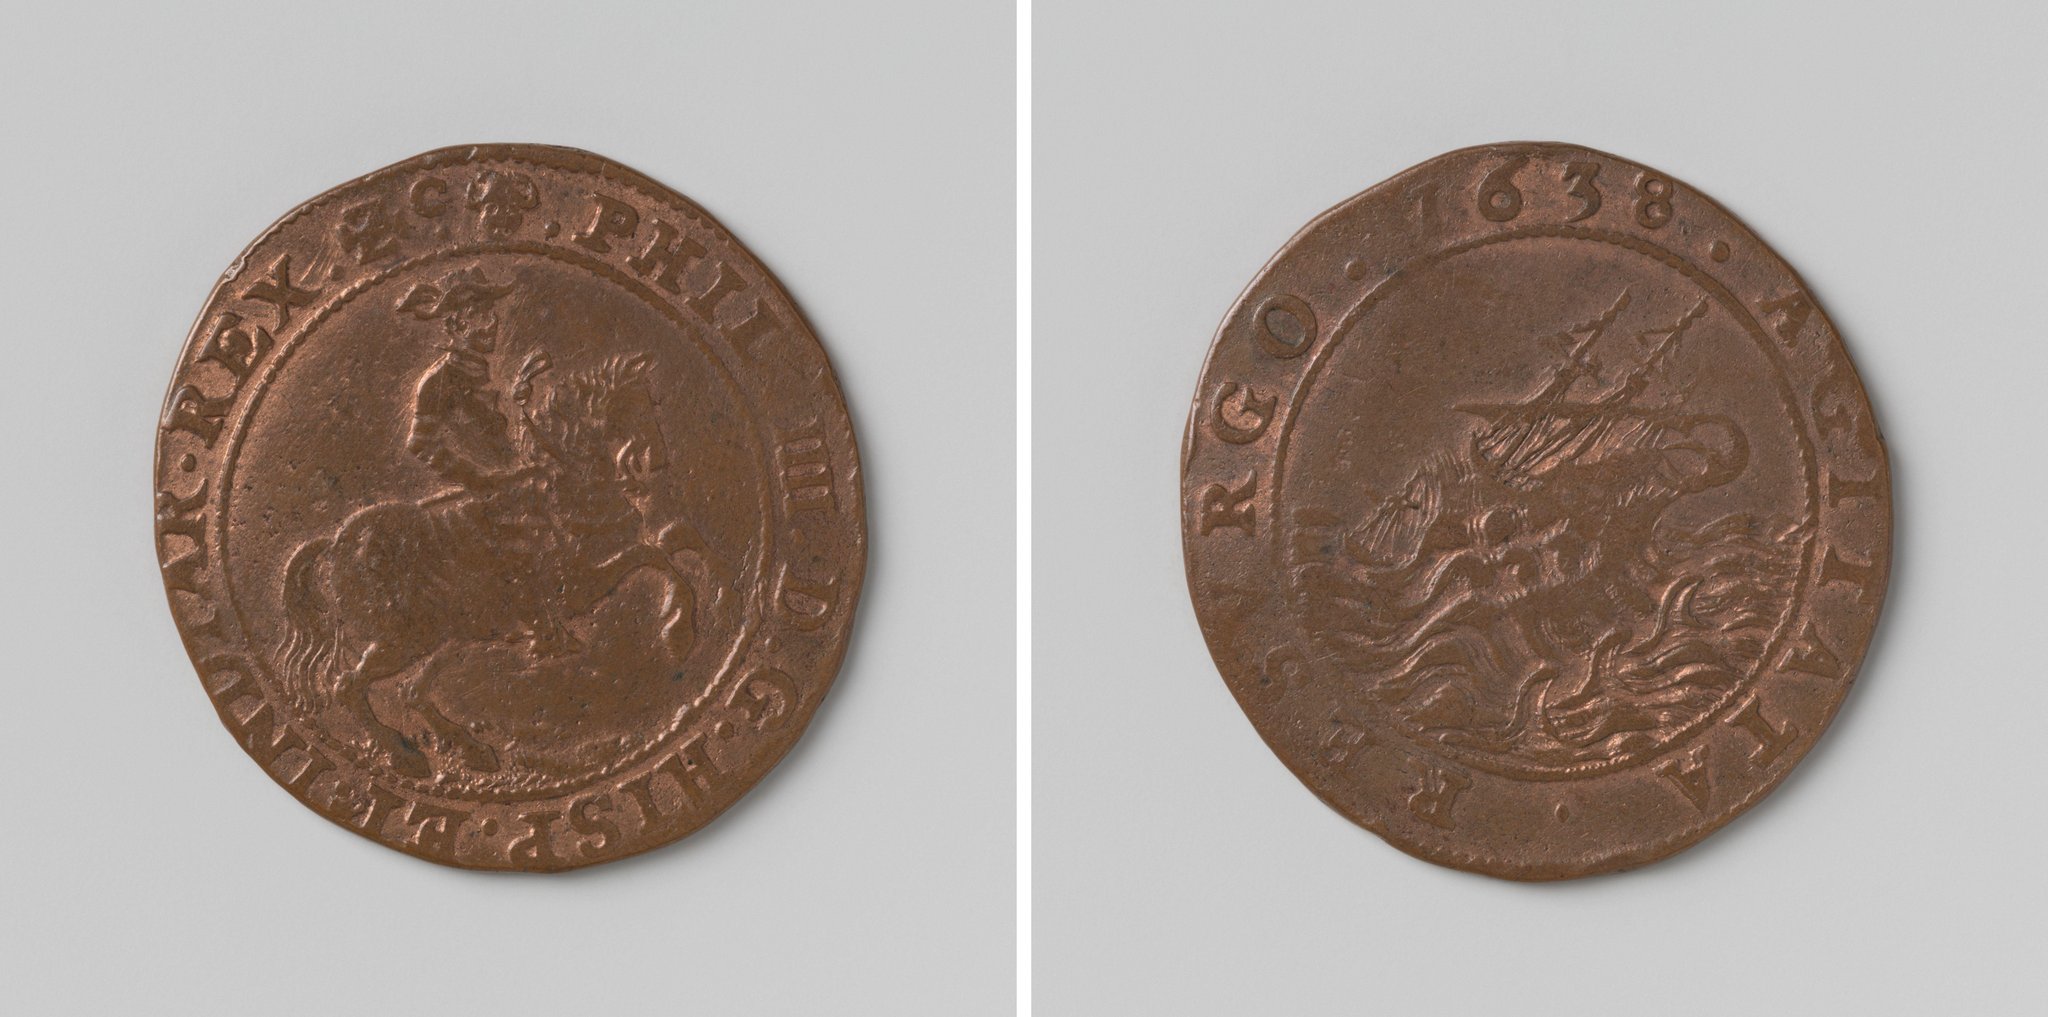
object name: jeton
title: Successen van de Spanjaarden, rekenpenning geslagen ter ere van Filips IV, koning van Spanje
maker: Anonymous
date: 1638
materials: copper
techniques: striking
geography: brussels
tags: filips iv (koning van spanje)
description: Koperen penning. Voorzijde: ruiter met commandstaf in hand binnen omschrift. Keerzijde: schip op open zee, geteisterd door storm binnen omschrift